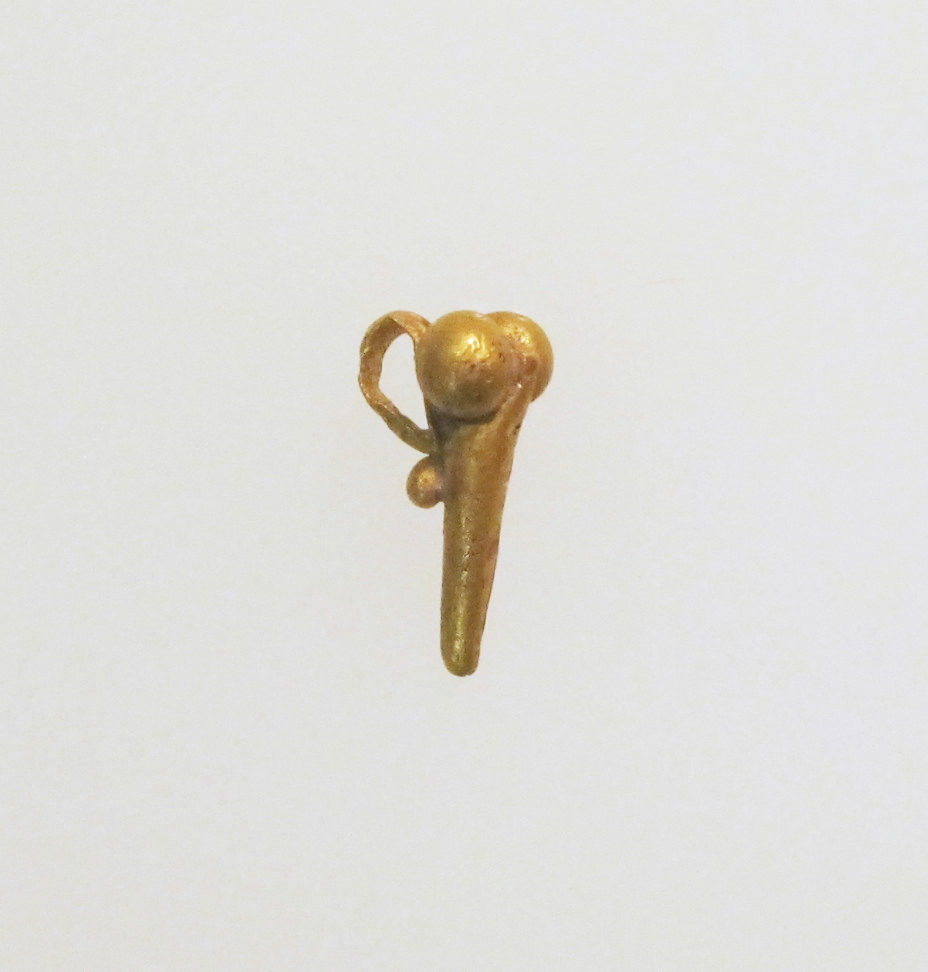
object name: pendant in the form of a phallos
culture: roman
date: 200 BCE-400 CE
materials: gold